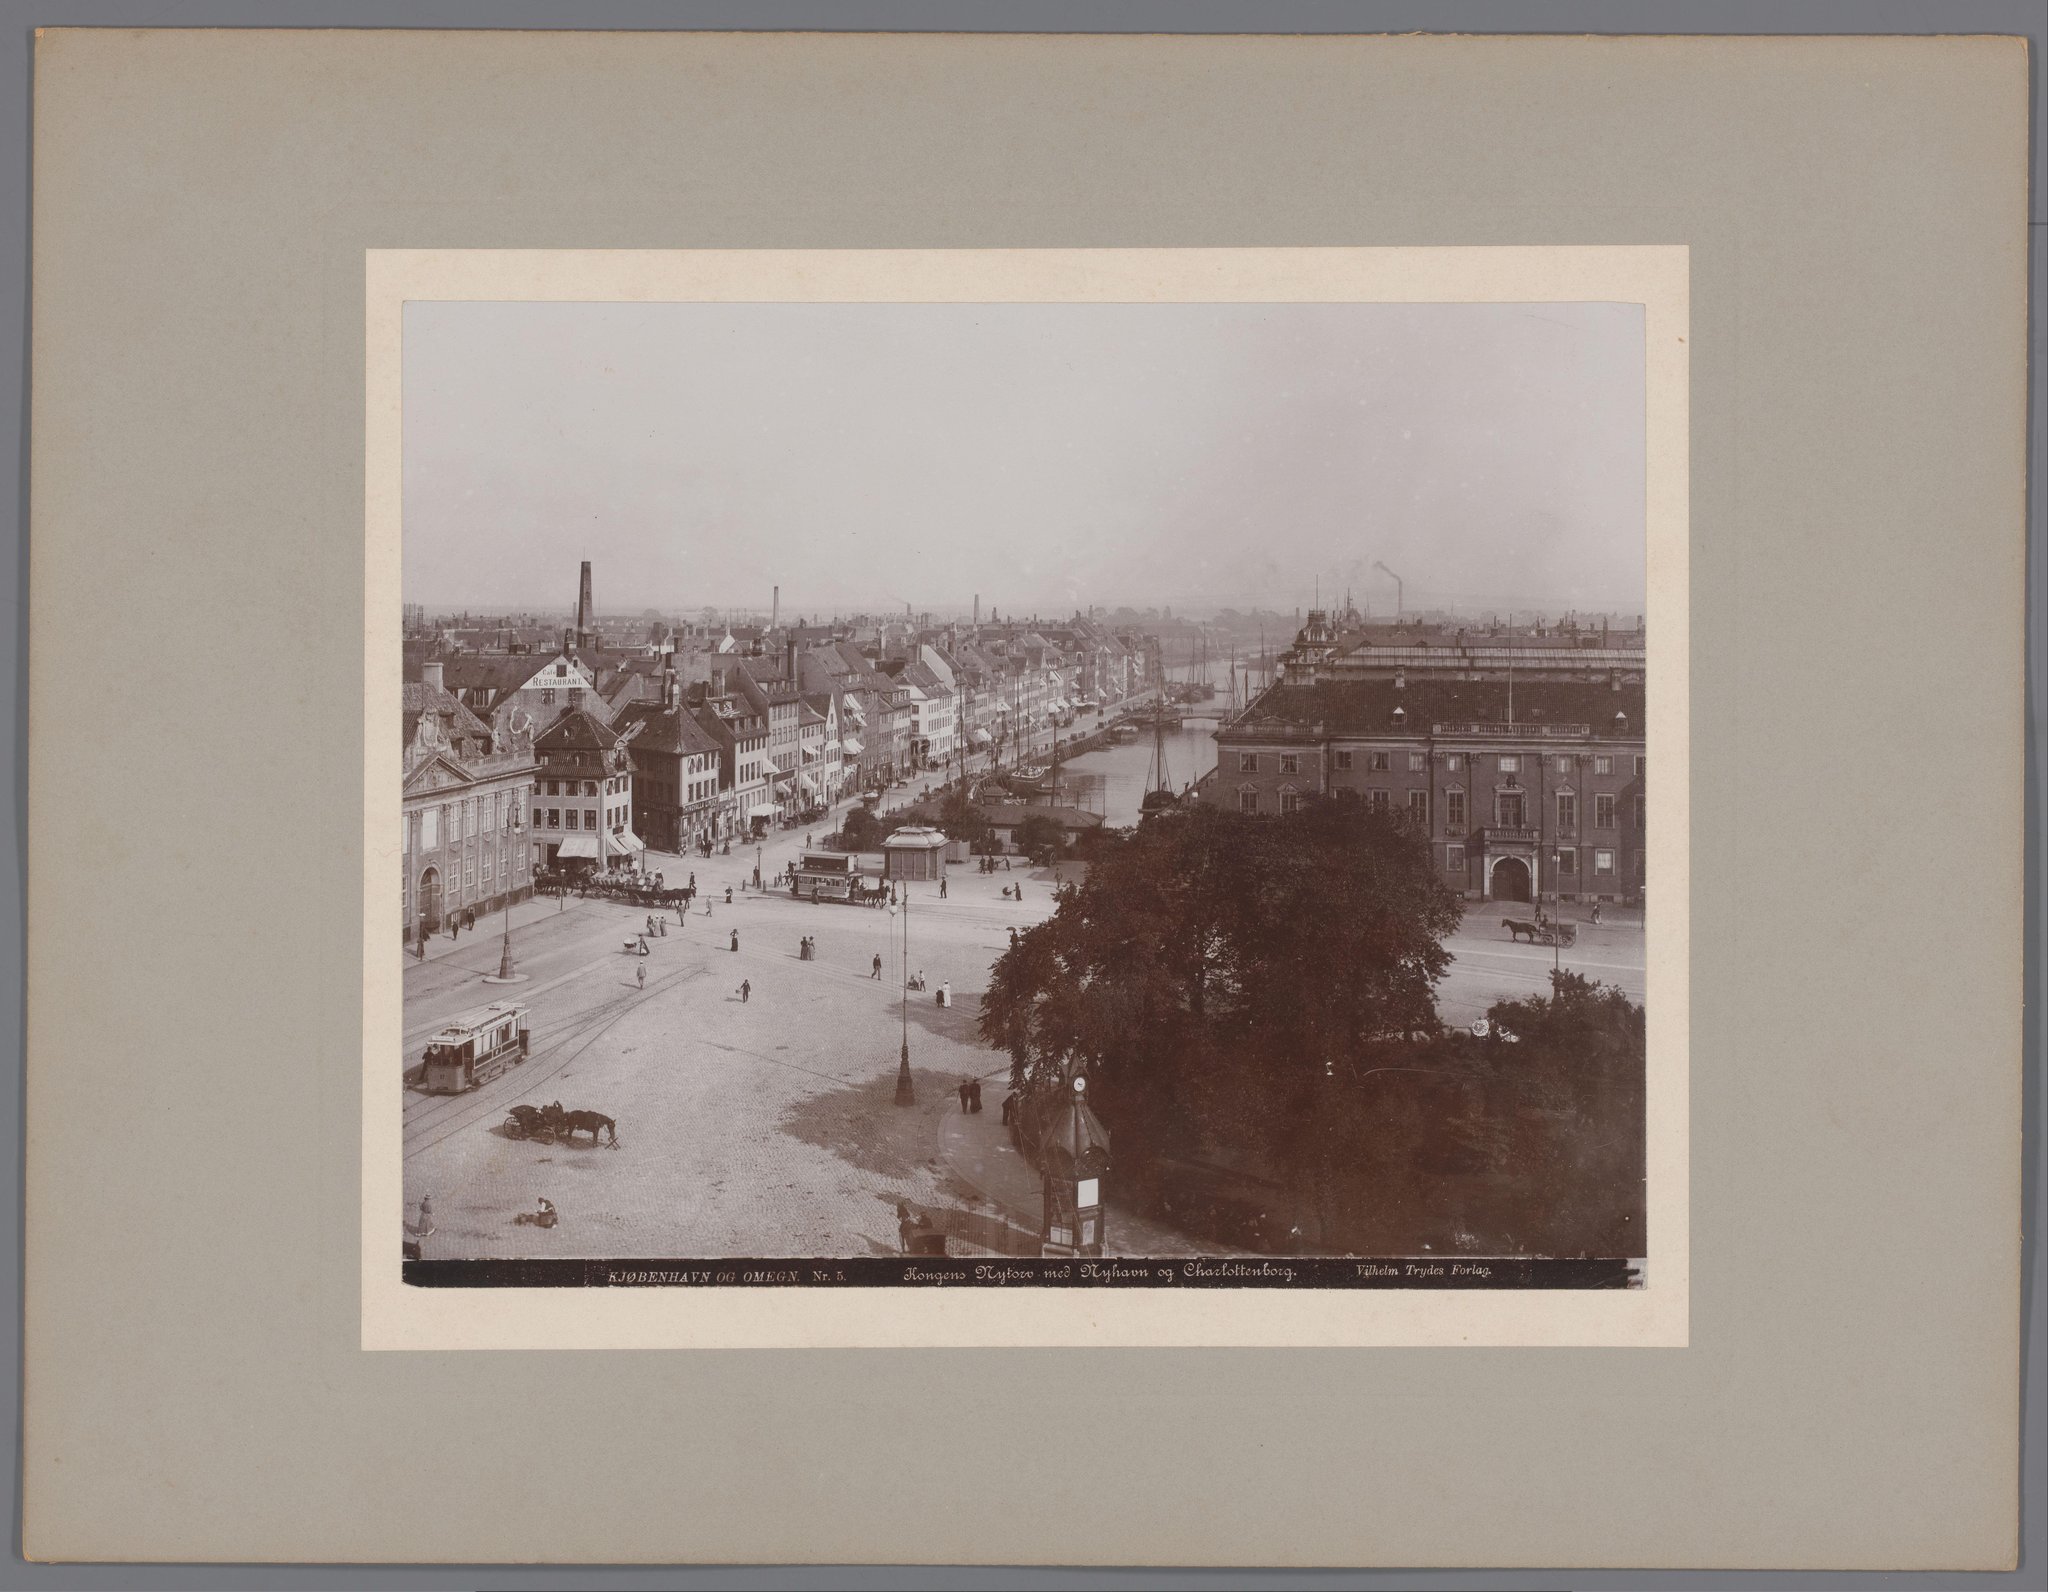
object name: photograph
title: Kongens Nytorv med Nyhavn og Charlottenborg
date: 1880-1910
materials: paper, cardboard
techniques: collodion silver print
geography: copenhagen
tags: harbour, square, place, circus, etc.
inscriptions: number: ‘Nr. 5.’